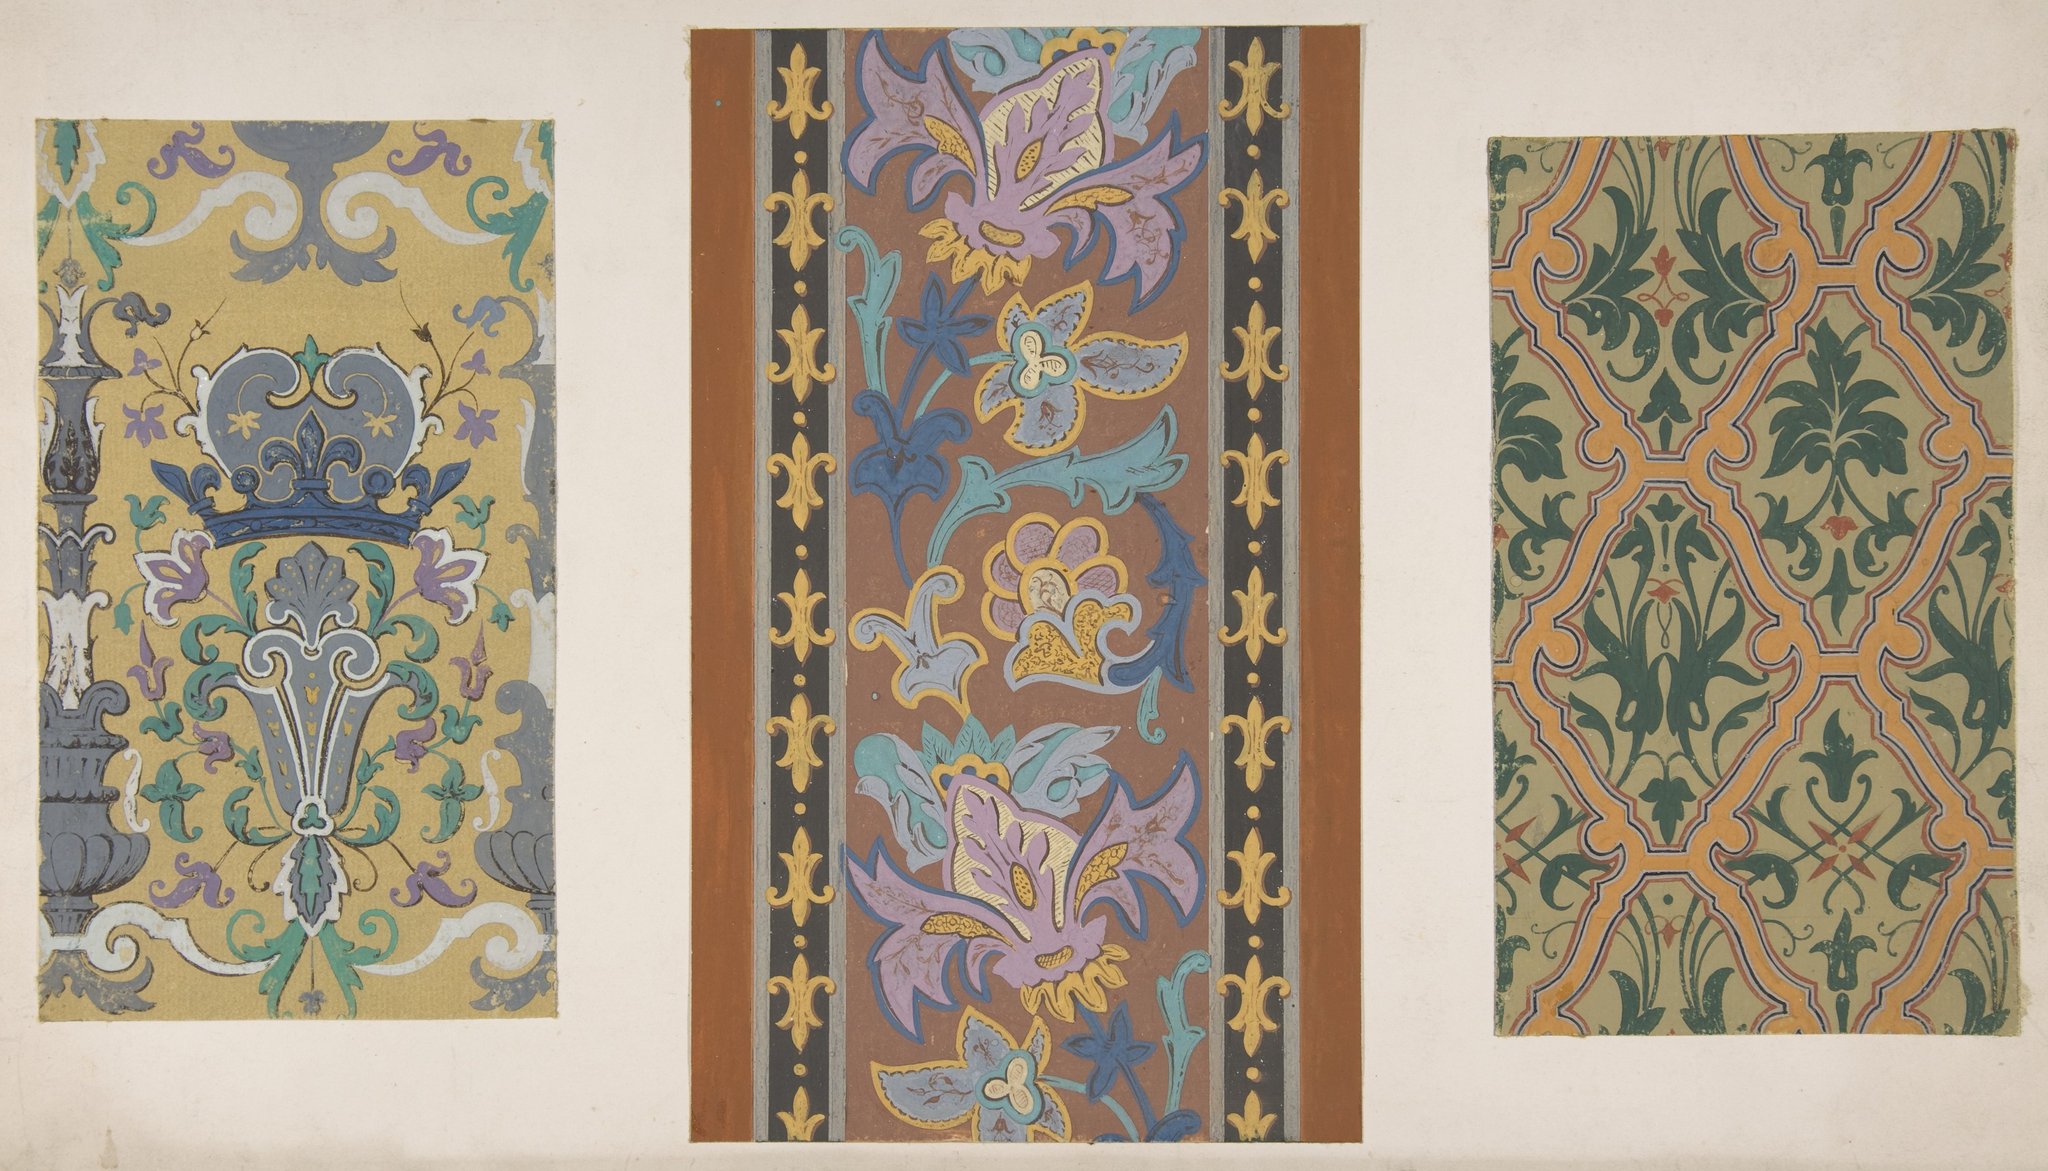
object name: drawing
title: Three designs for wallpaper featuring strapwork, rinceaux, and fleurs-de-lis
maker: jules-edmond-charles lachaise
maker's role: artist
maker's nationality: french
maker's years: 1897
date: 1830-1897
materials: cardboard, gouache, paper